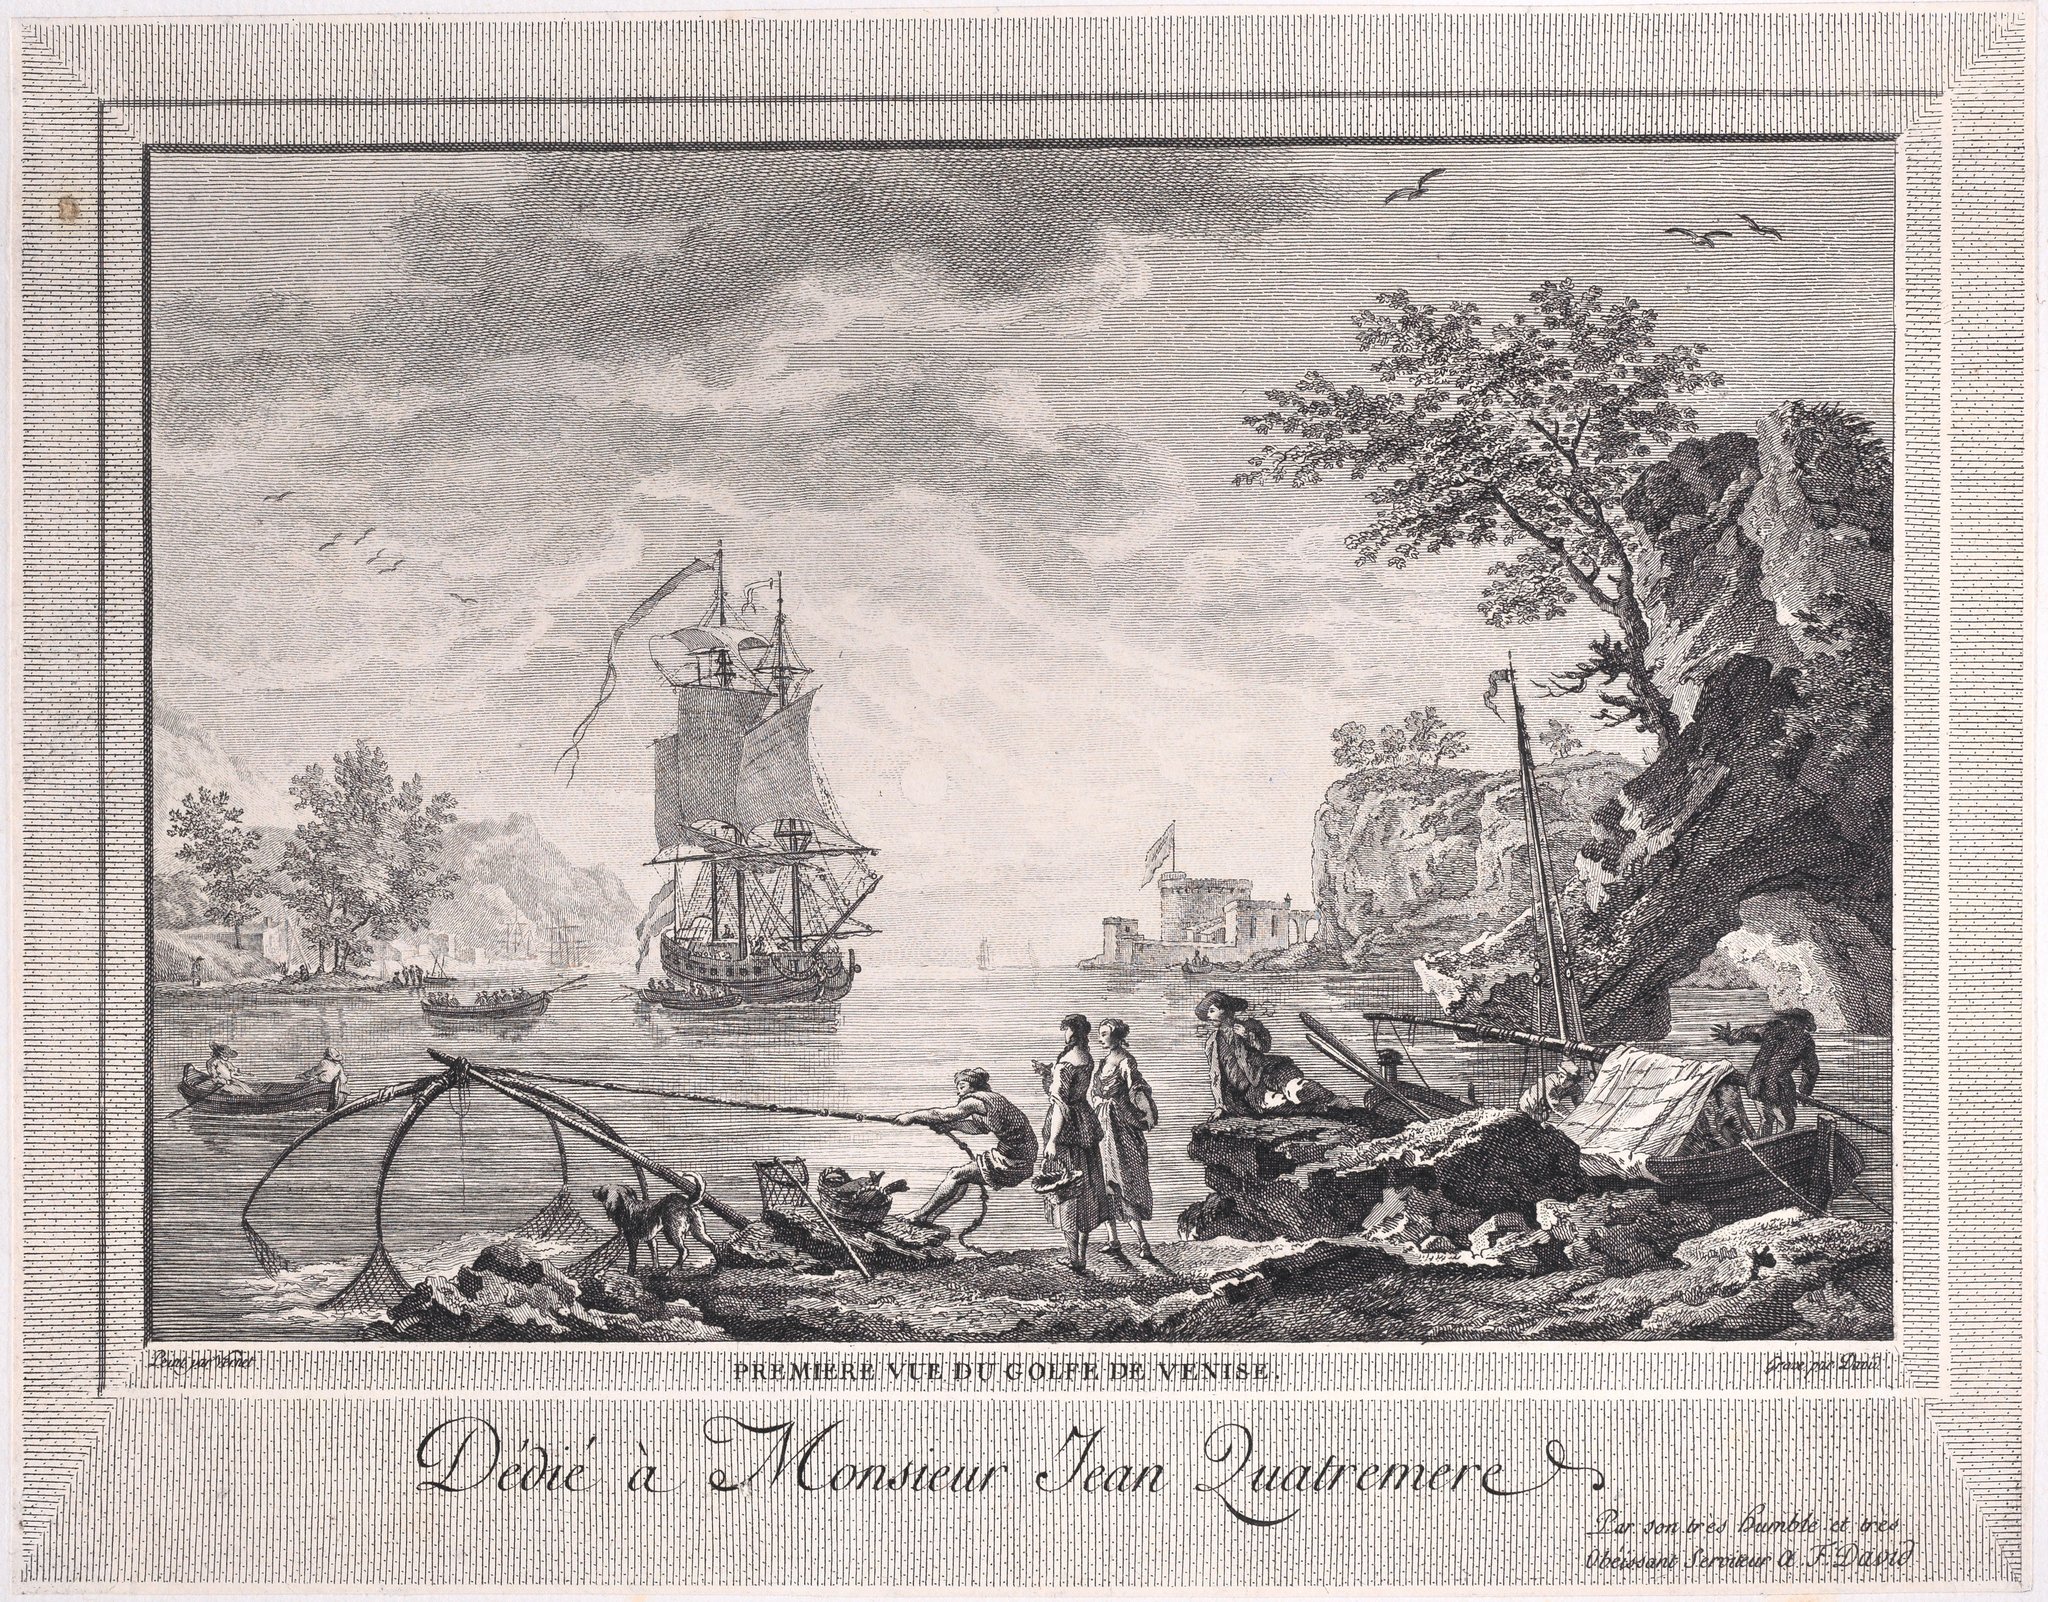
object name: print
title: First View of the Gulf of Venice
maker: joseph vernet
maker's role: artist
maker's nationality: french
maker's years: 1714-1789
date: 1770-1800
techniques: engraving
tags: venice